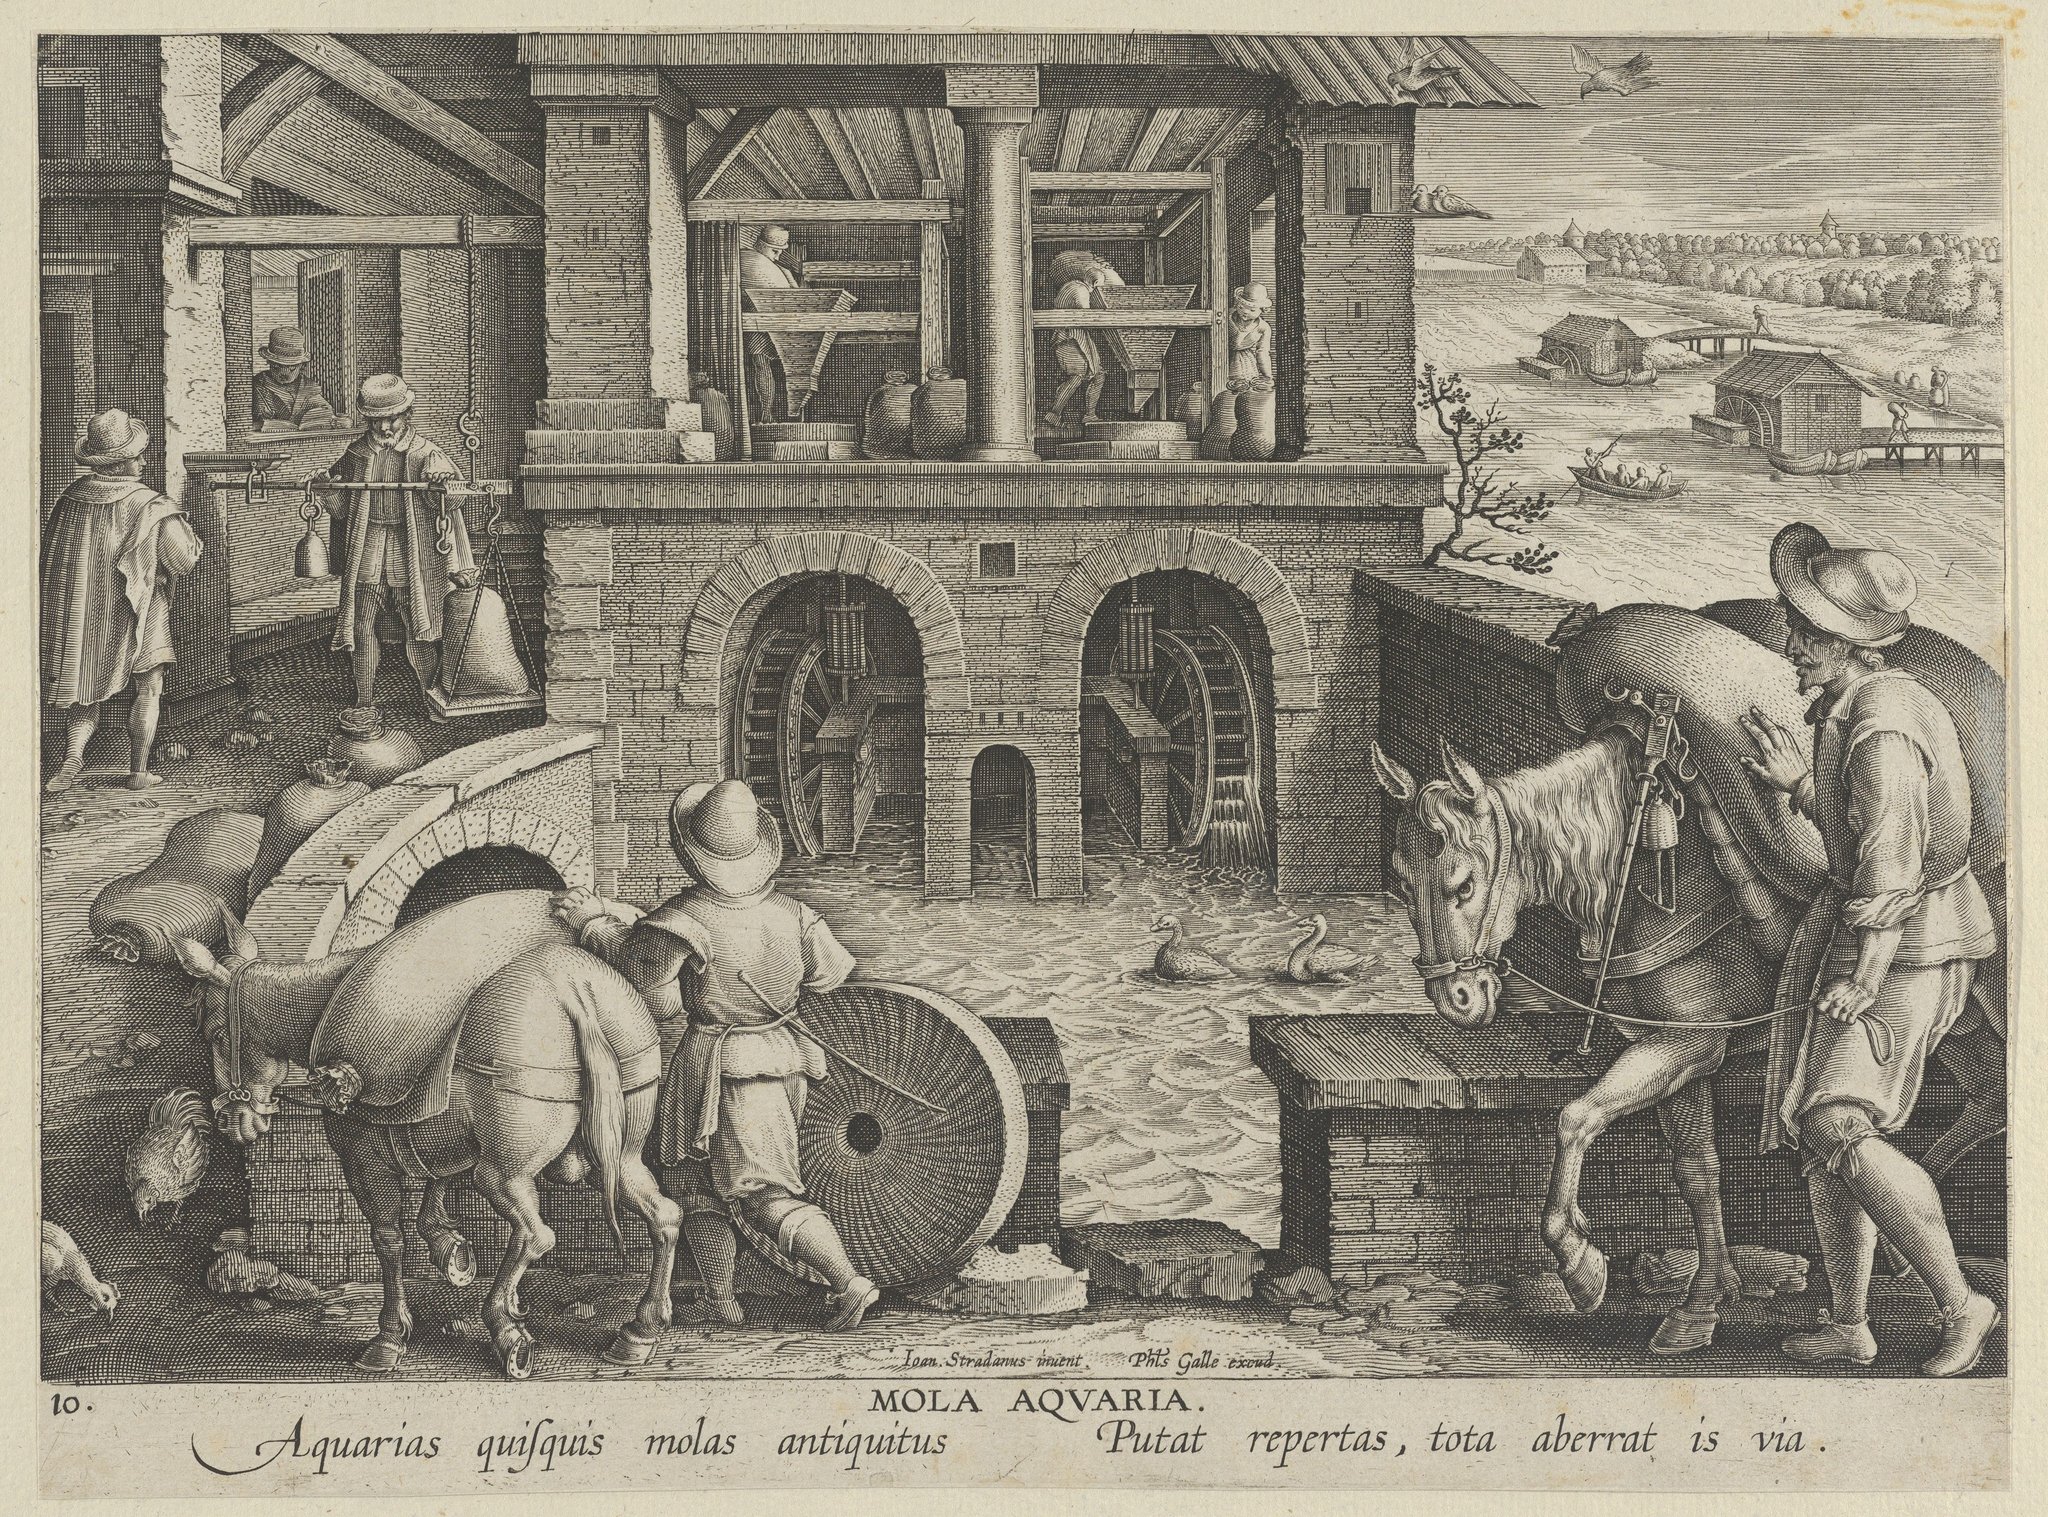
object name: print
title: New Inventions of Modern Times [Nova Reperta], The Invention of the Watermill, plate 10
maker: jan collaert i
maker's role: artist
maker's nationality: netherlandish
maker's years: 1530-1581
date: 1600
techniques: engraving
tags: watermills,men,donkeys,working